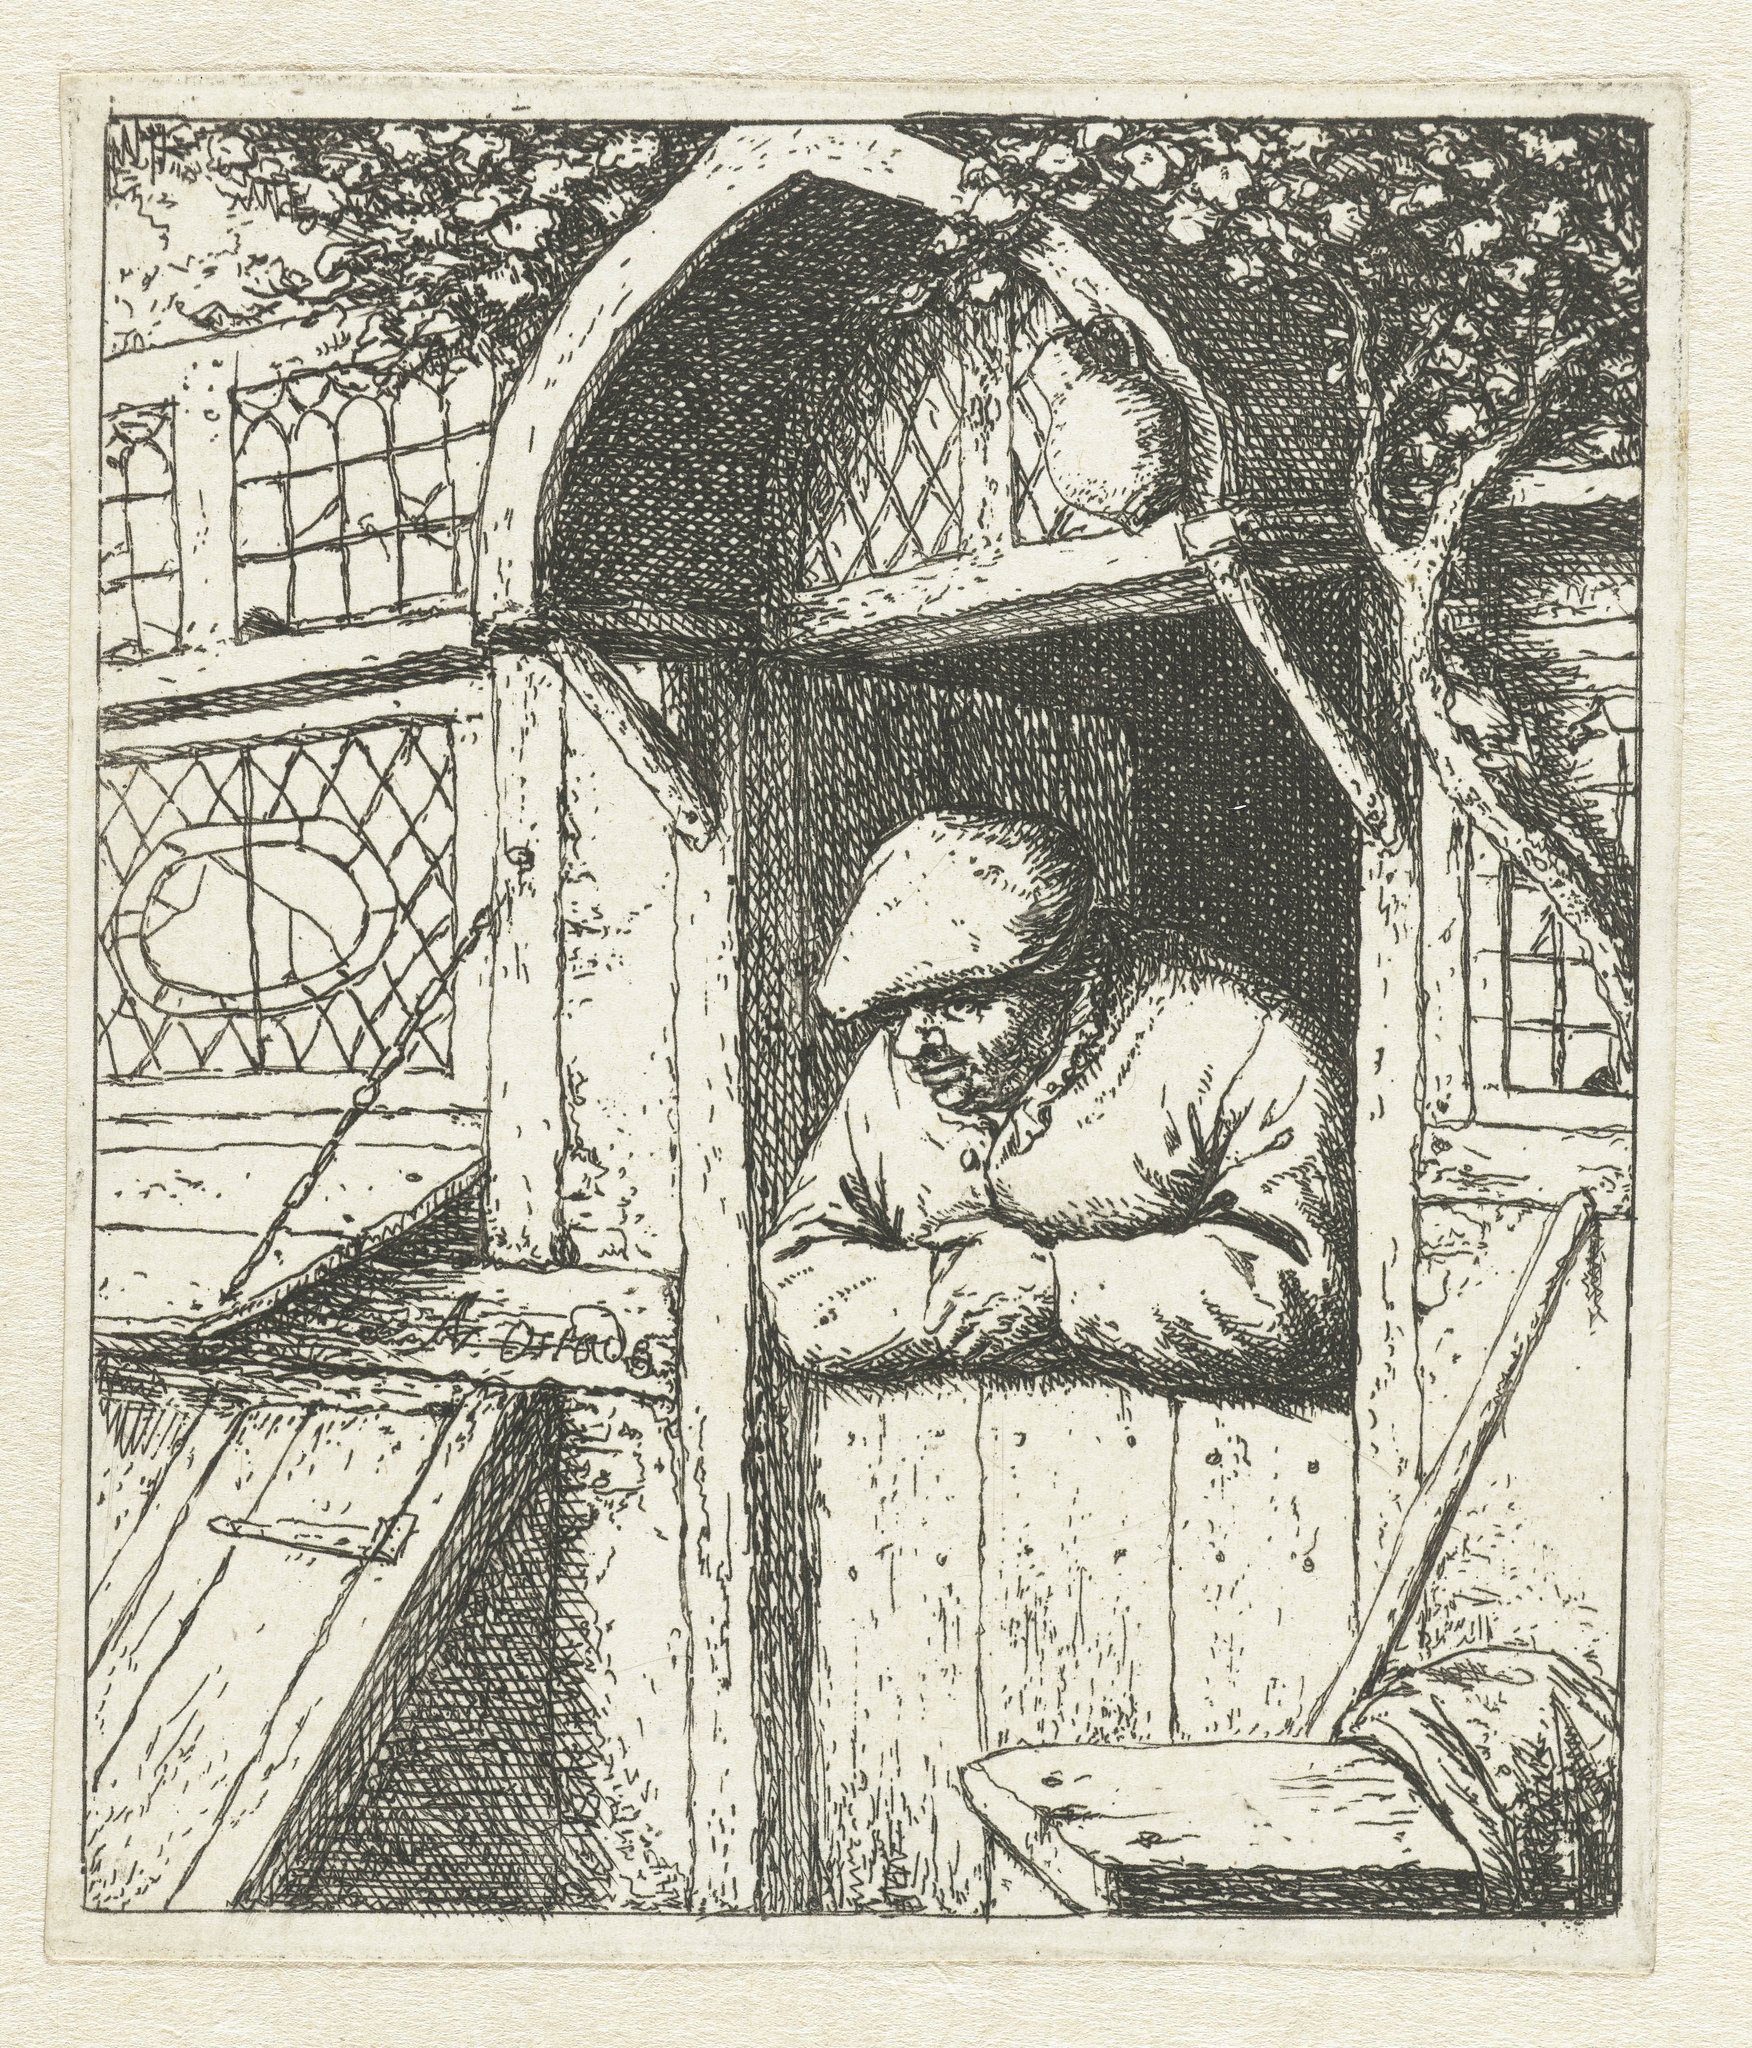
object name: print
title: Boer leunend op onderdeur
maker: adriaen van ostade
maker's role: draughtsman, painter, print maker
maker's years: 1610-1685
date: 1651-1655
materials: paper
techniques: etching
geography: haarlem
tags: divided door, upper part opened, male sex; man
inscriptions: collector's mark: Lugt 2228a